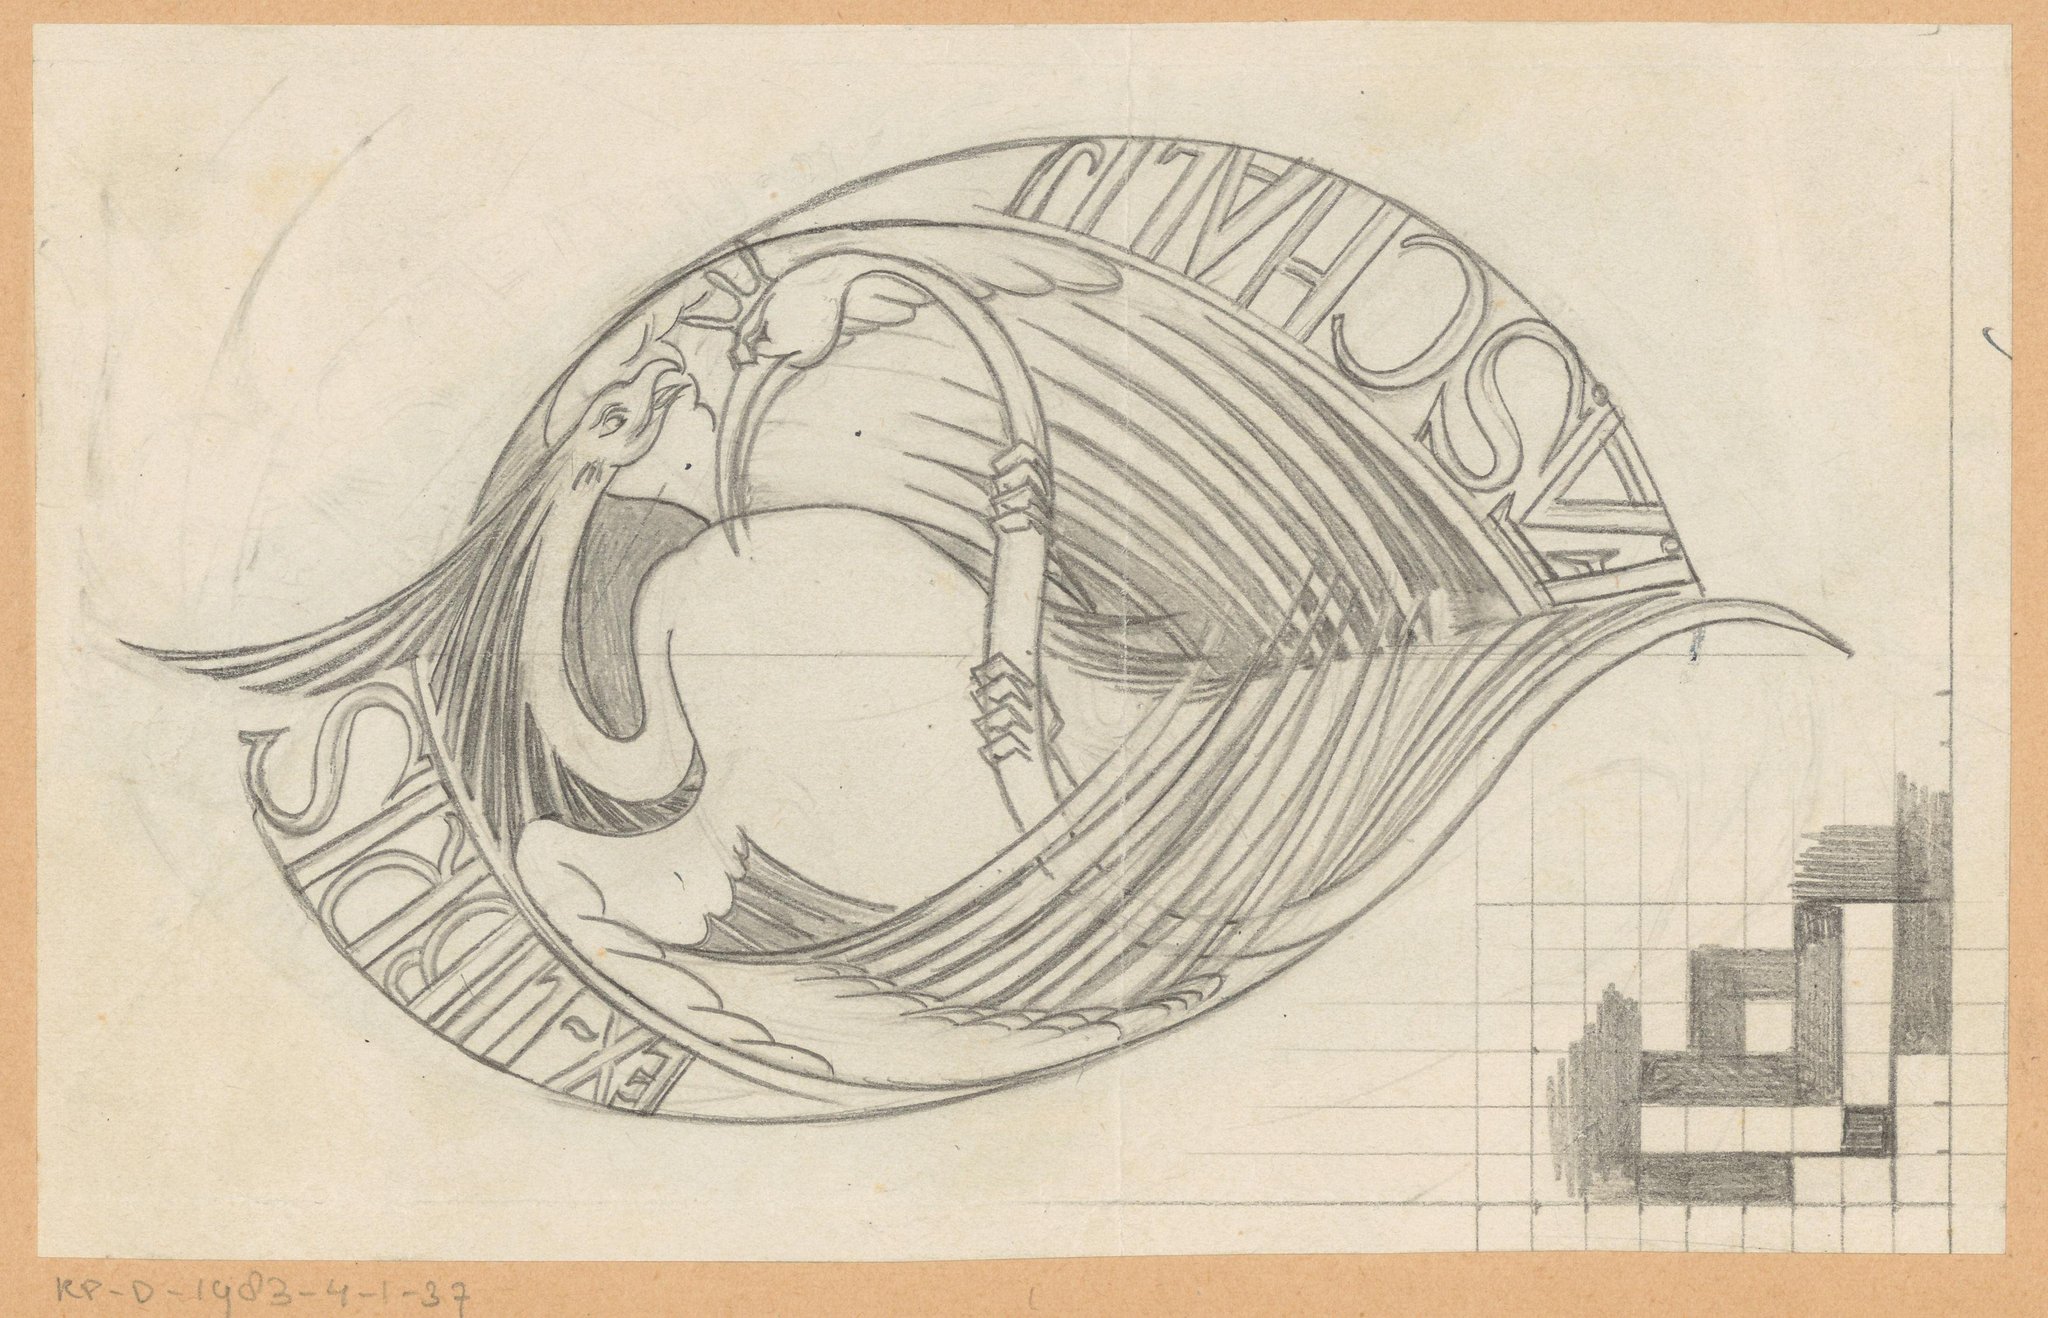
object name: bookplate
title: Ex-libris F.A. Schaly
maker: otto verhagen (i)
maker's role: draughtsman, print maker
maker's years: 1885-1951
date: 1929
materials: paper, pencil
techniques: drawing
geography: netherlands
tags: snakes, birds